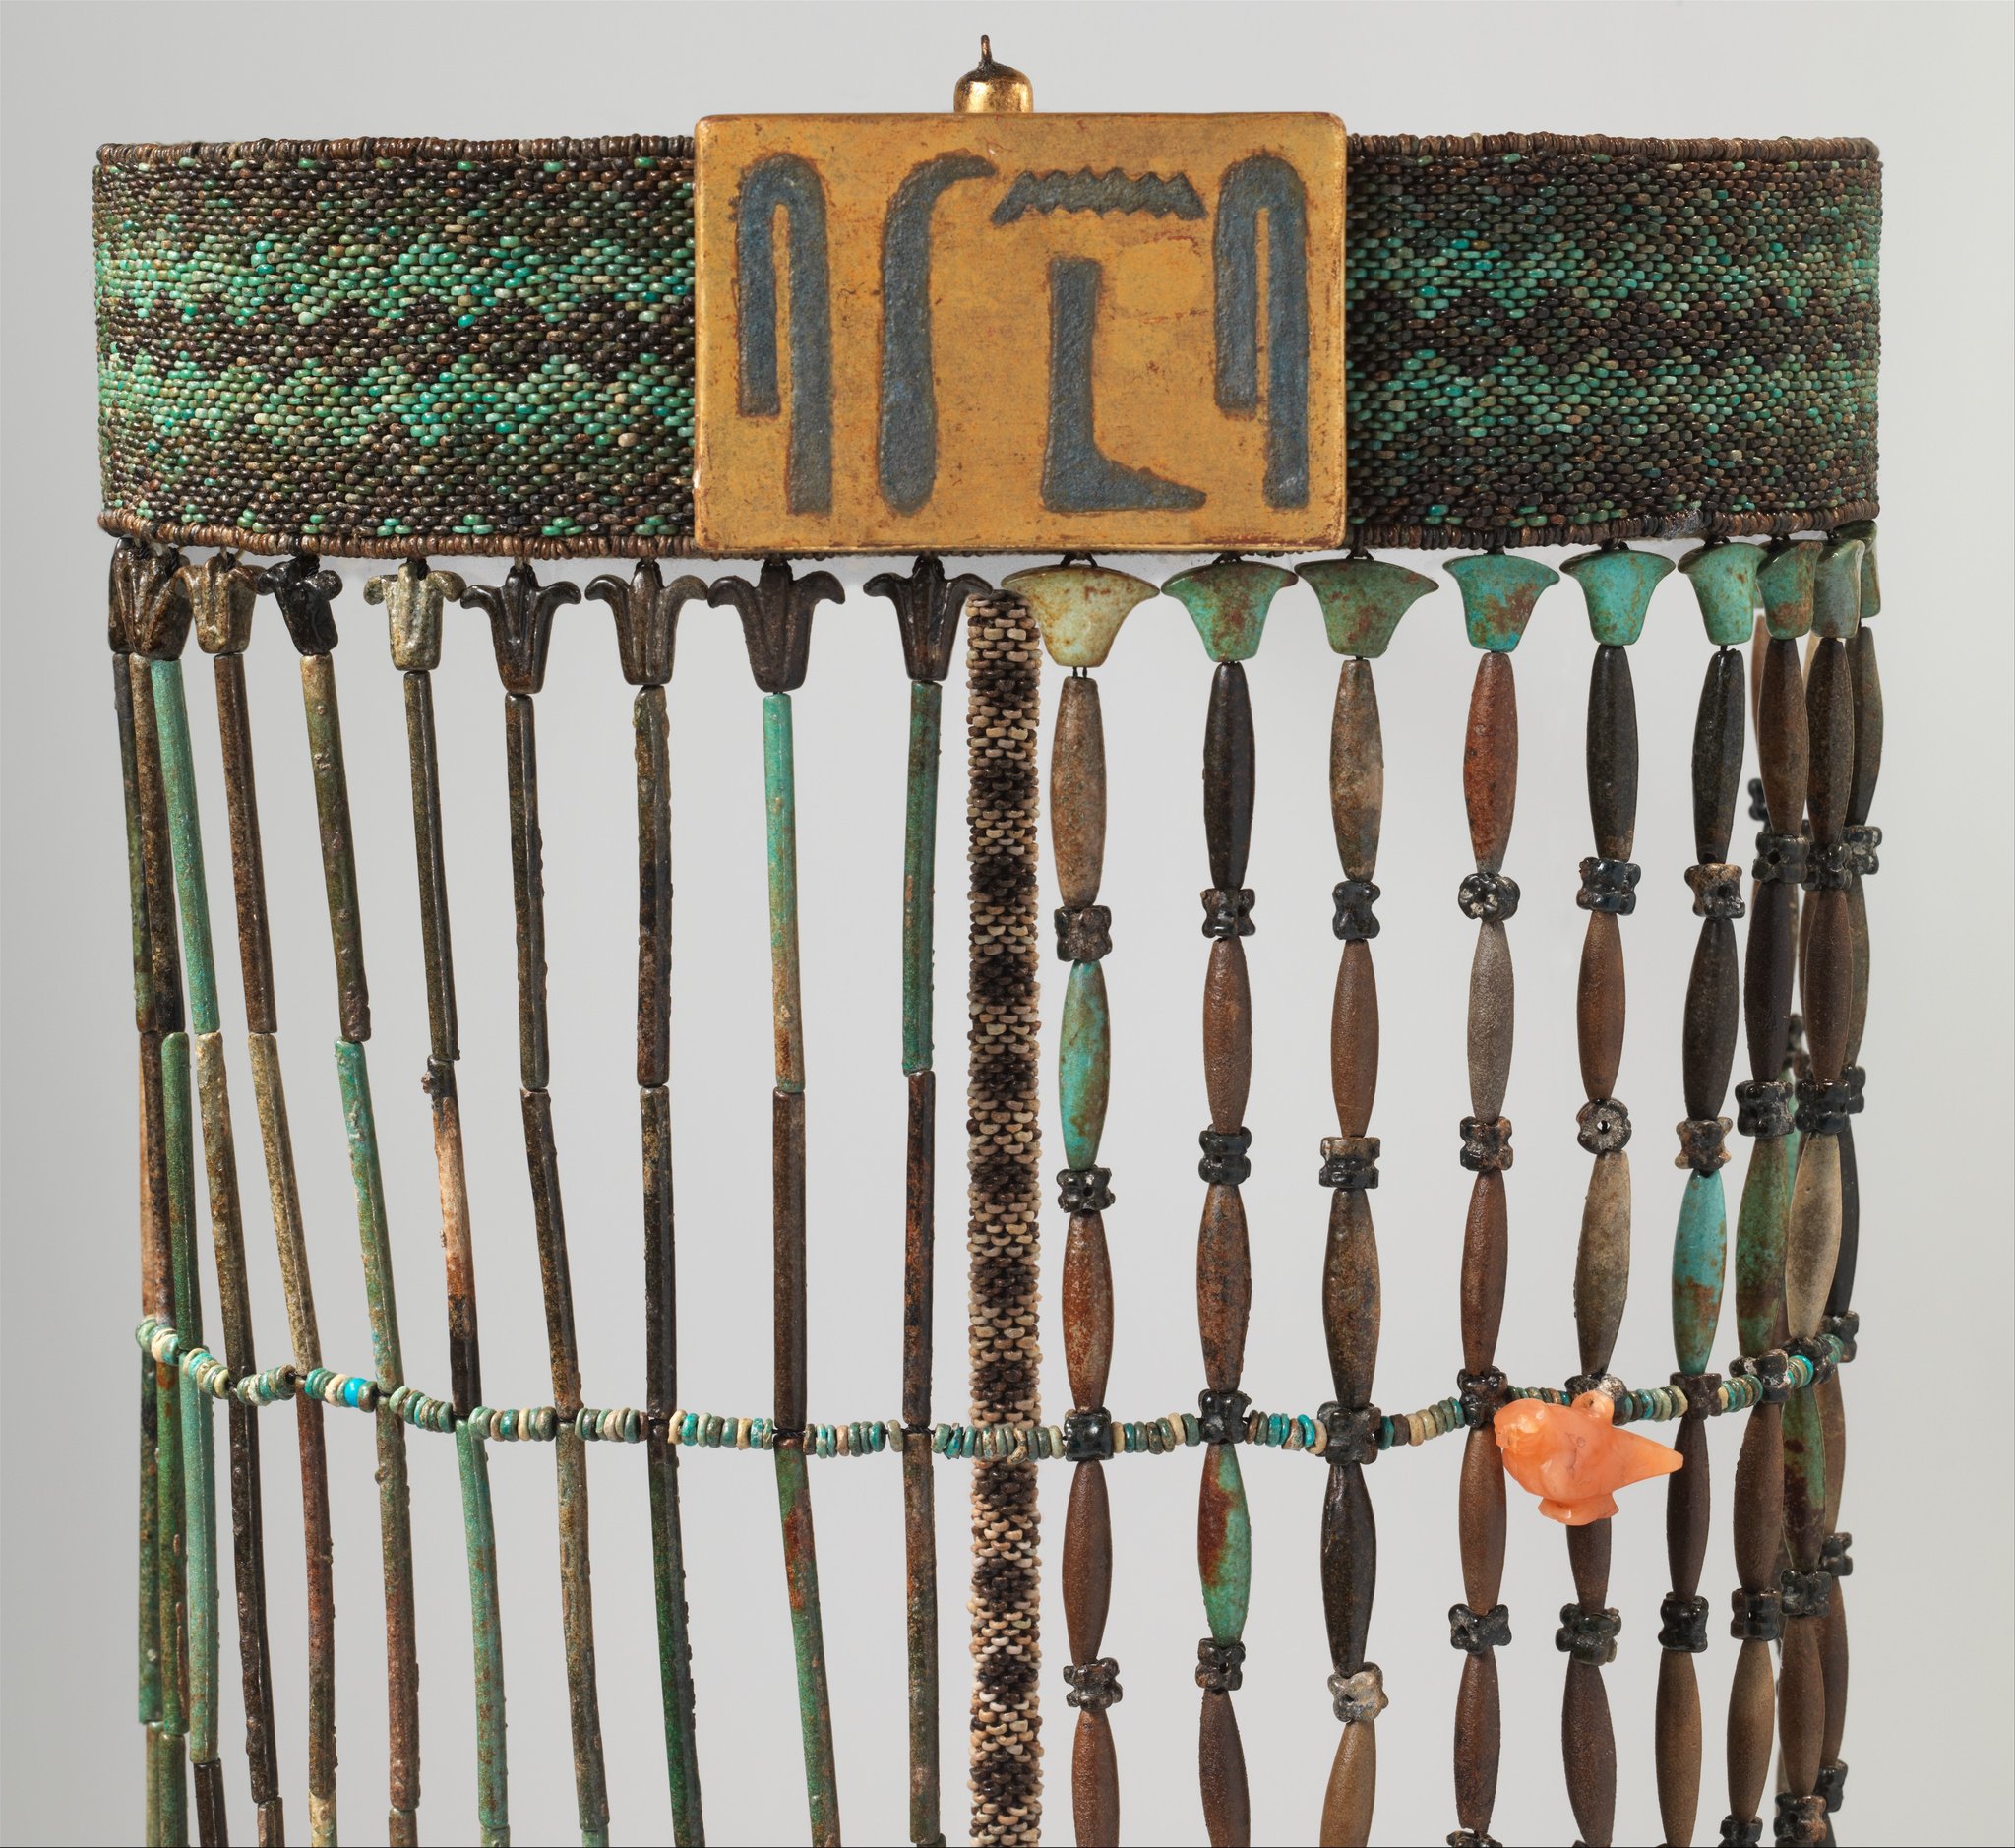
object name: apron, beadwork, senebtisi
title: Belt of beadwork apron of Senebtisi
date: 1850-1775 BCE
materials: faience, paint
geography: egypt